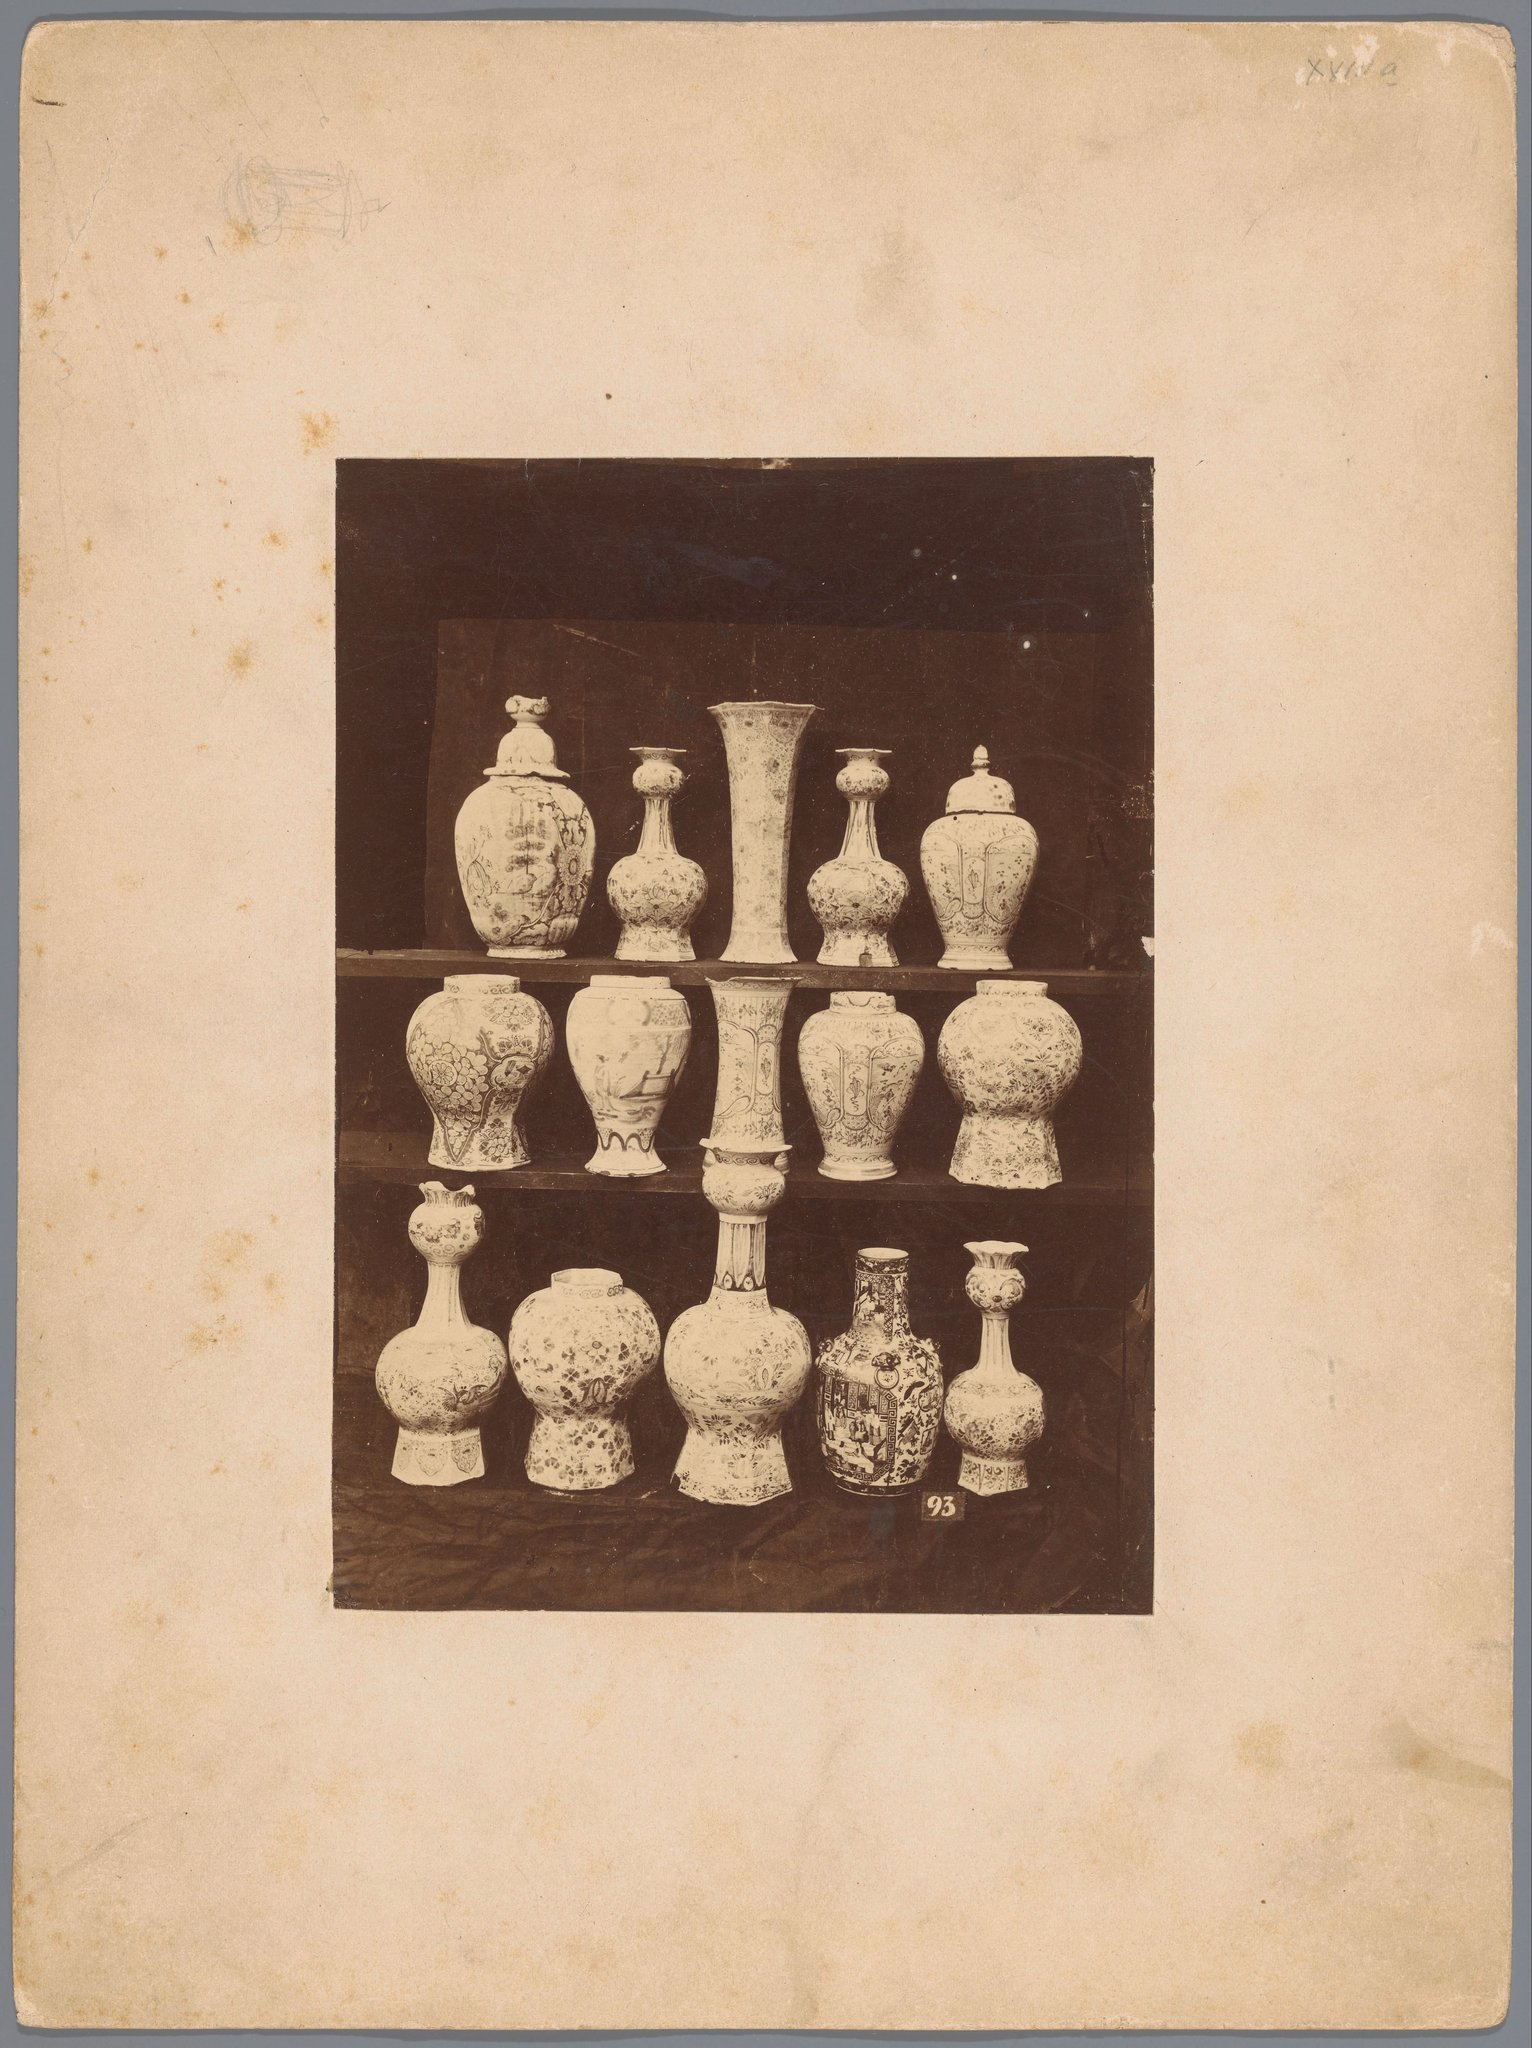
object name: photograph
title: Vijftien vazen en potten, vermoedelijk een kaststel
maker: Anonymous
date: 1875-1900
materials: cardboard, photographic support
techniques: albumen print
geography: europe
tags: container of ceramics: jar, jug, pot, vase, ornamenting, decorating ~ applied arts, europe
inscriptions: collector's mark: Lugt 3937, number: ‘XXI[...]’